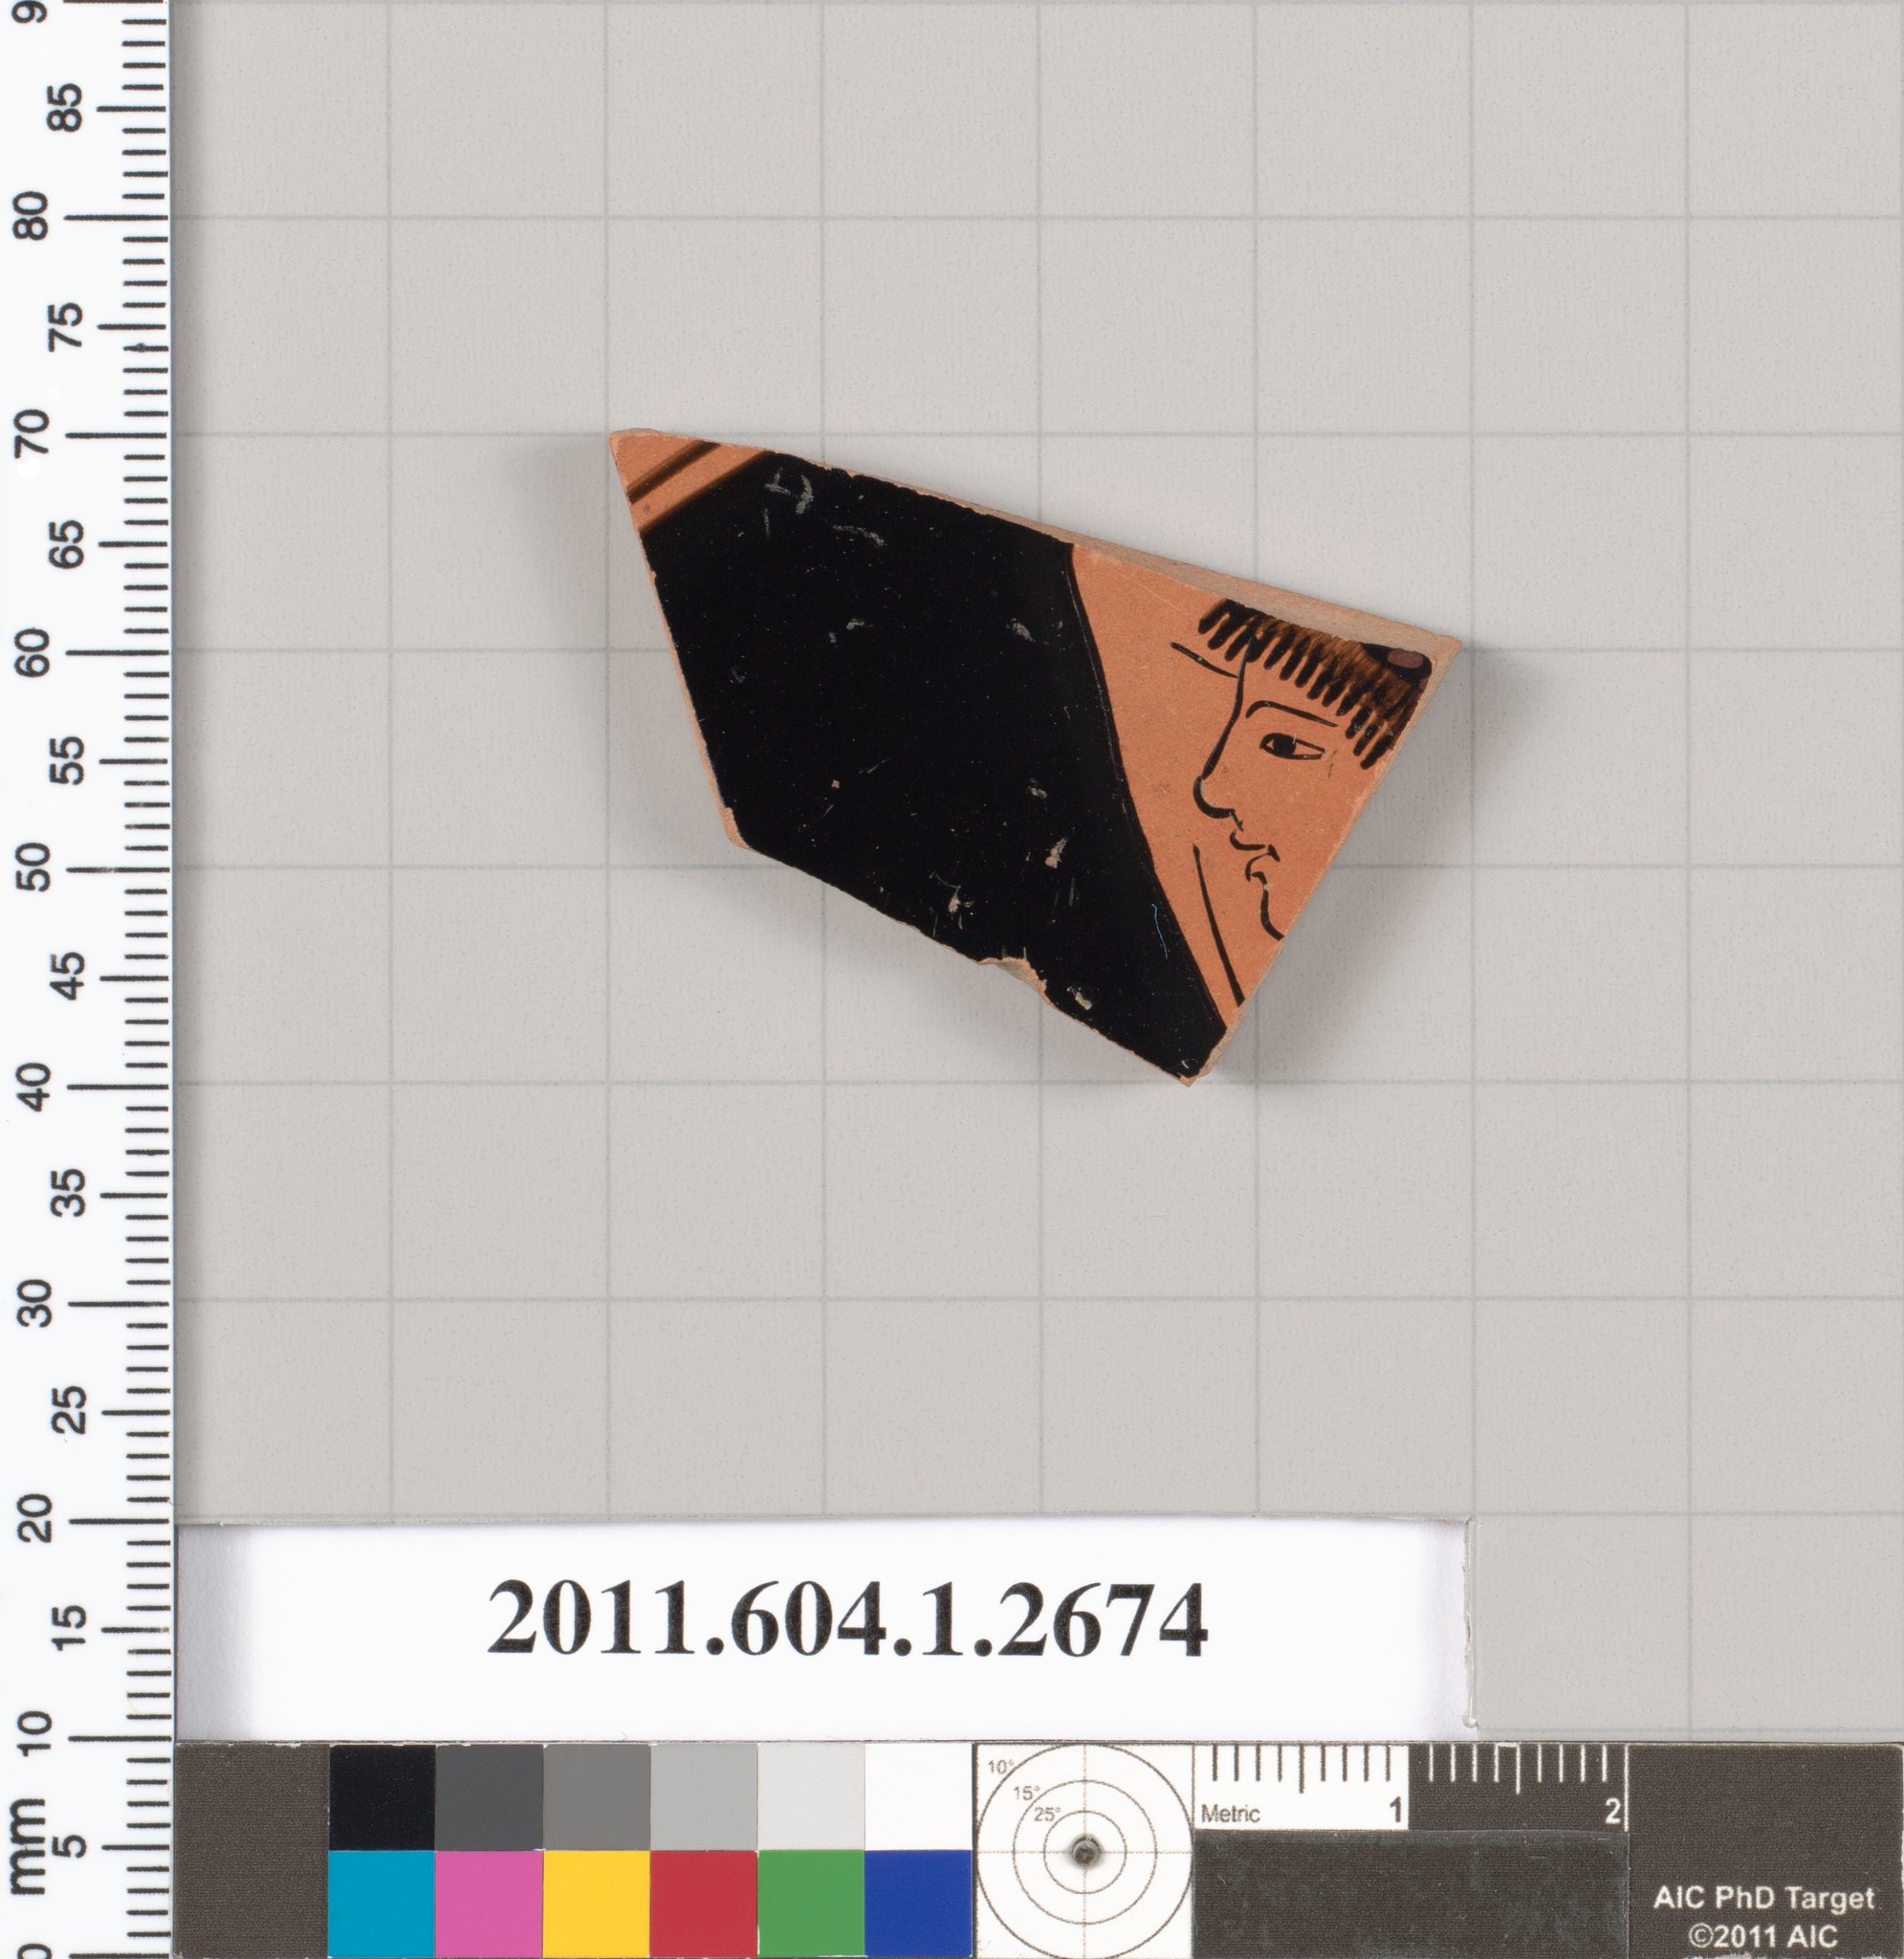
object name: kylix fragment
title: Terracotta fragment of a kylix (drinking cup)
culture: greek, attic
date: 500-480 BCE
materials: terracotta